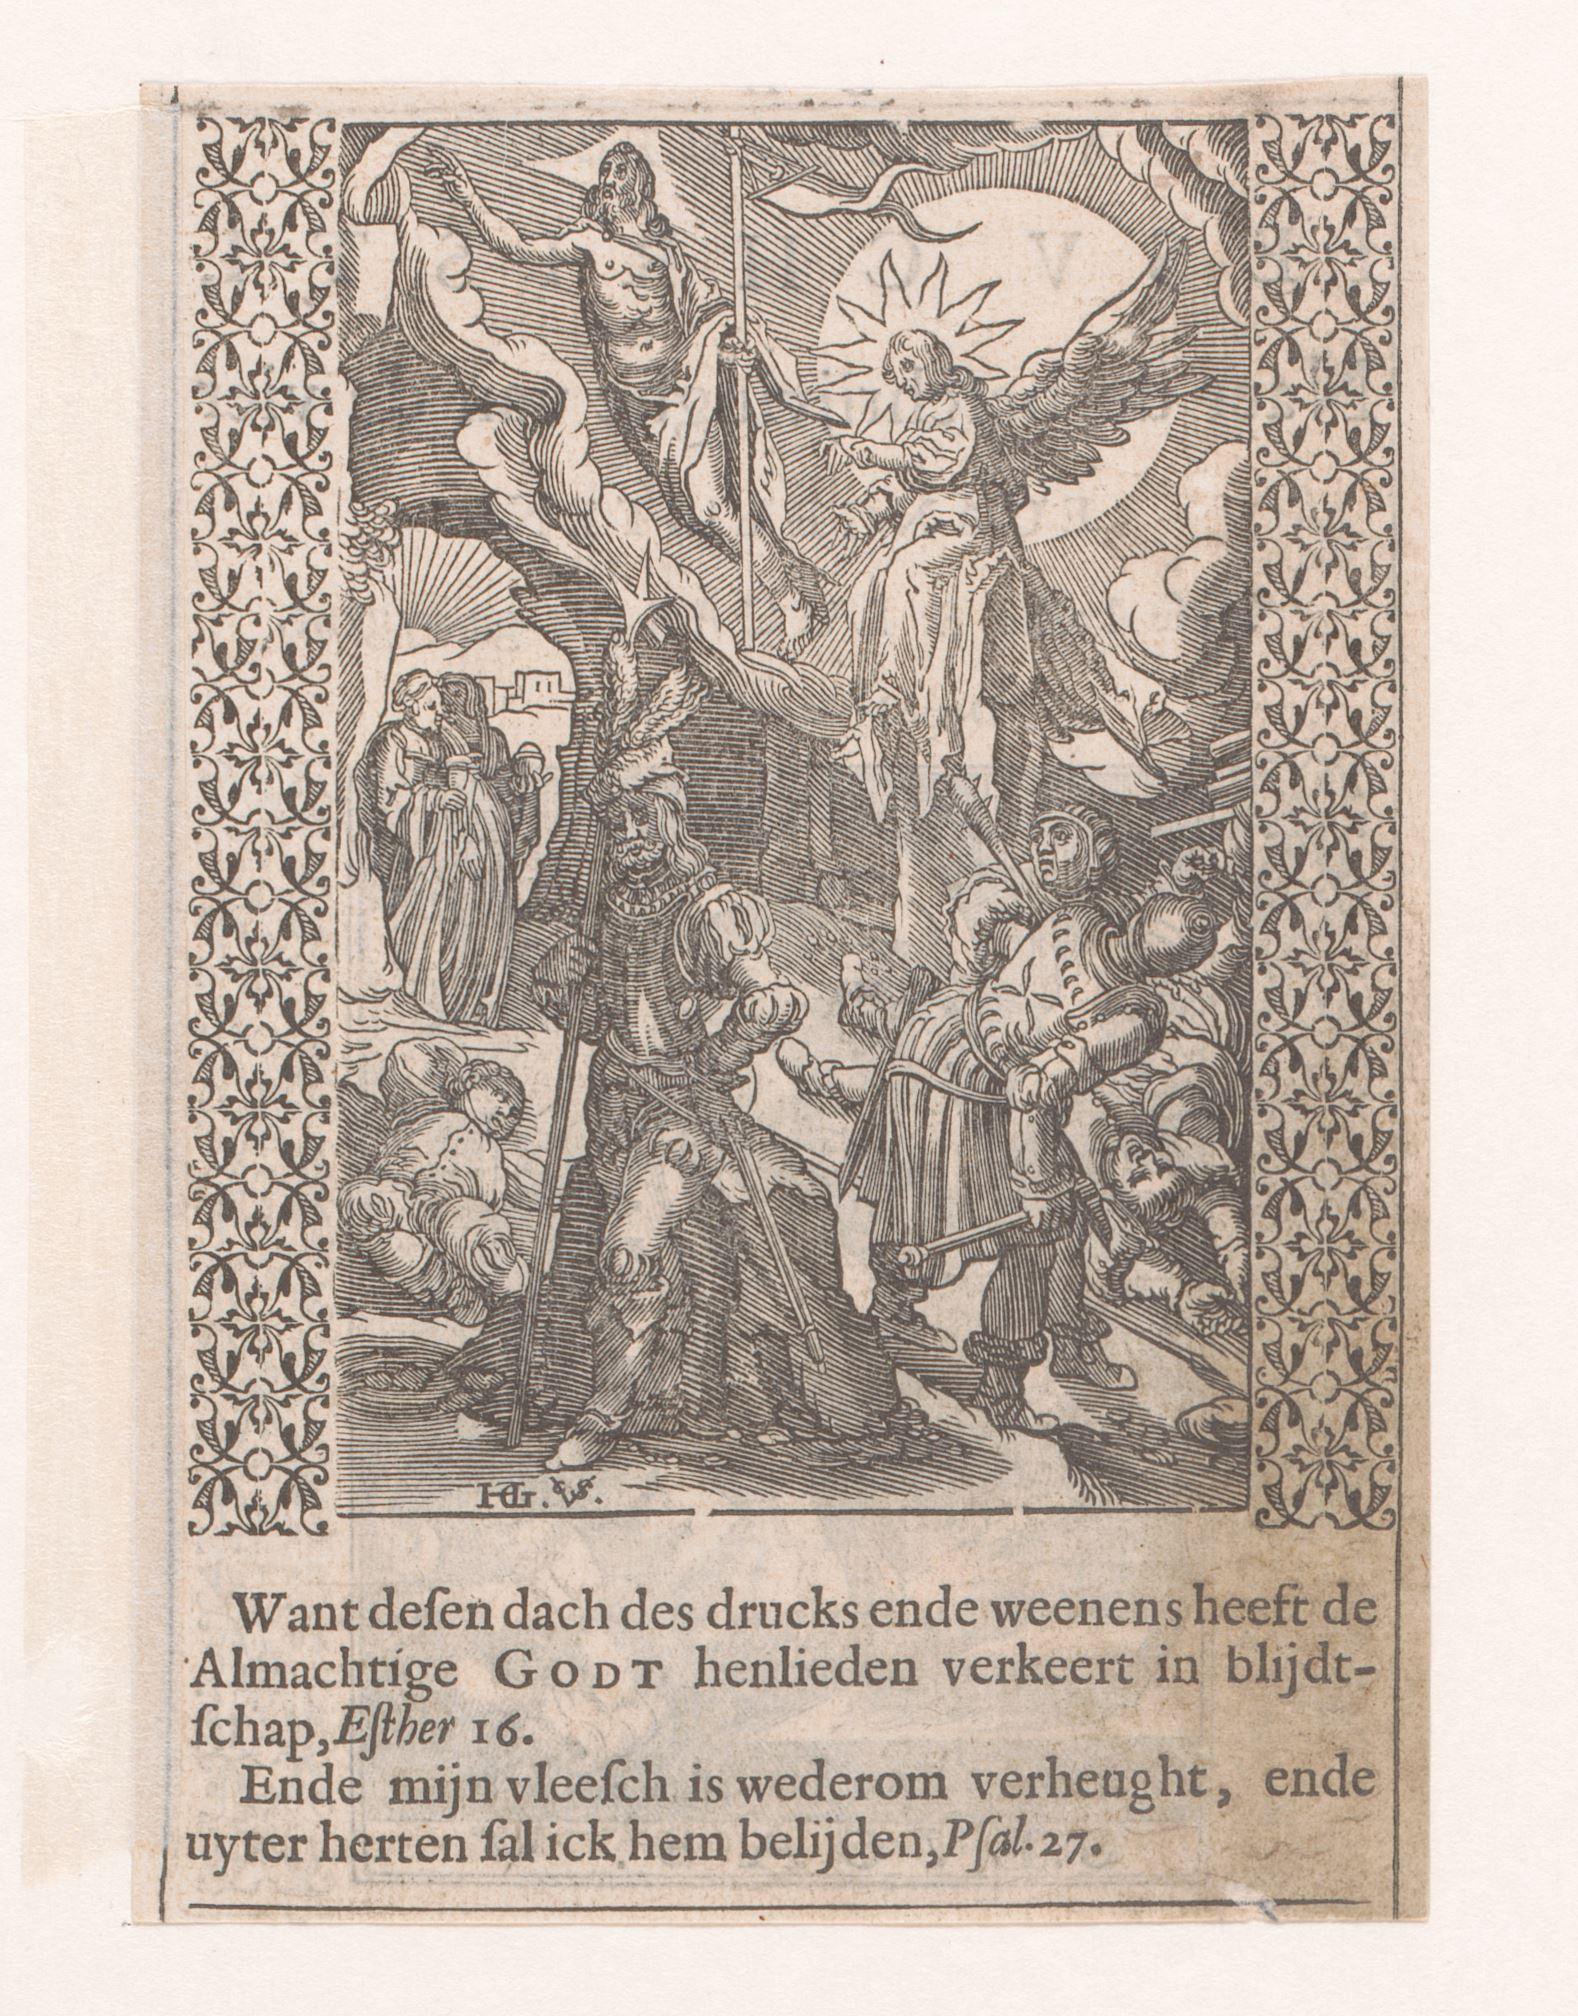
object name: print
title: Opstanding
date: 1648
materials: paper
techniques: letterpress printing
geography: amsterdam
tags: christ, usually holding a banner, arises from the grave; often combined with sleeping and/or frightened soldiers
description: Prent uit: 't Schat der Zielen, dat is, het geheele leven ons Heeren Iesu Christi naer de vyer Evangelisten (...) in zeven stucken verdeelt. Amsterdam: Pieter Jacobsz. Paets, 1648.